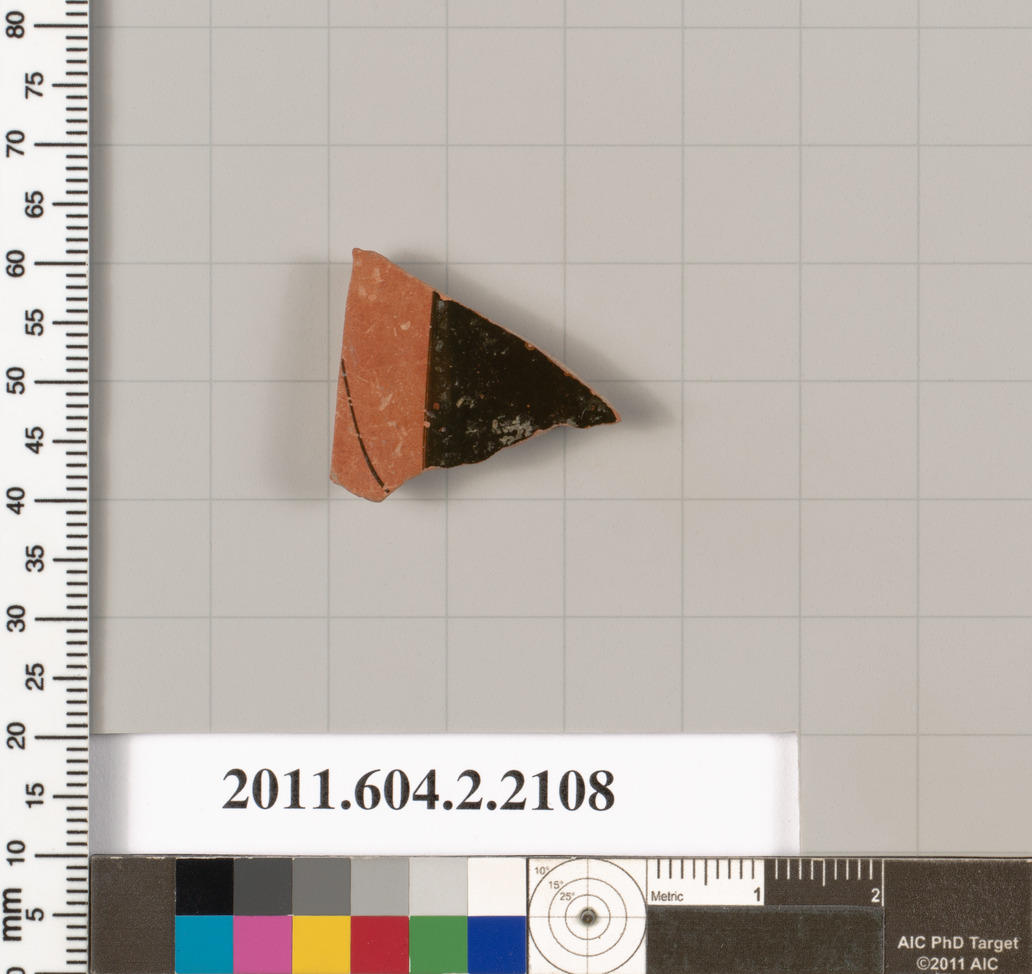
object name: pot fragment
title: Terracotta fragment of a pot; glazed on the inside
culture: greek, attic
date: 475-451 BCE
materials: terracotta